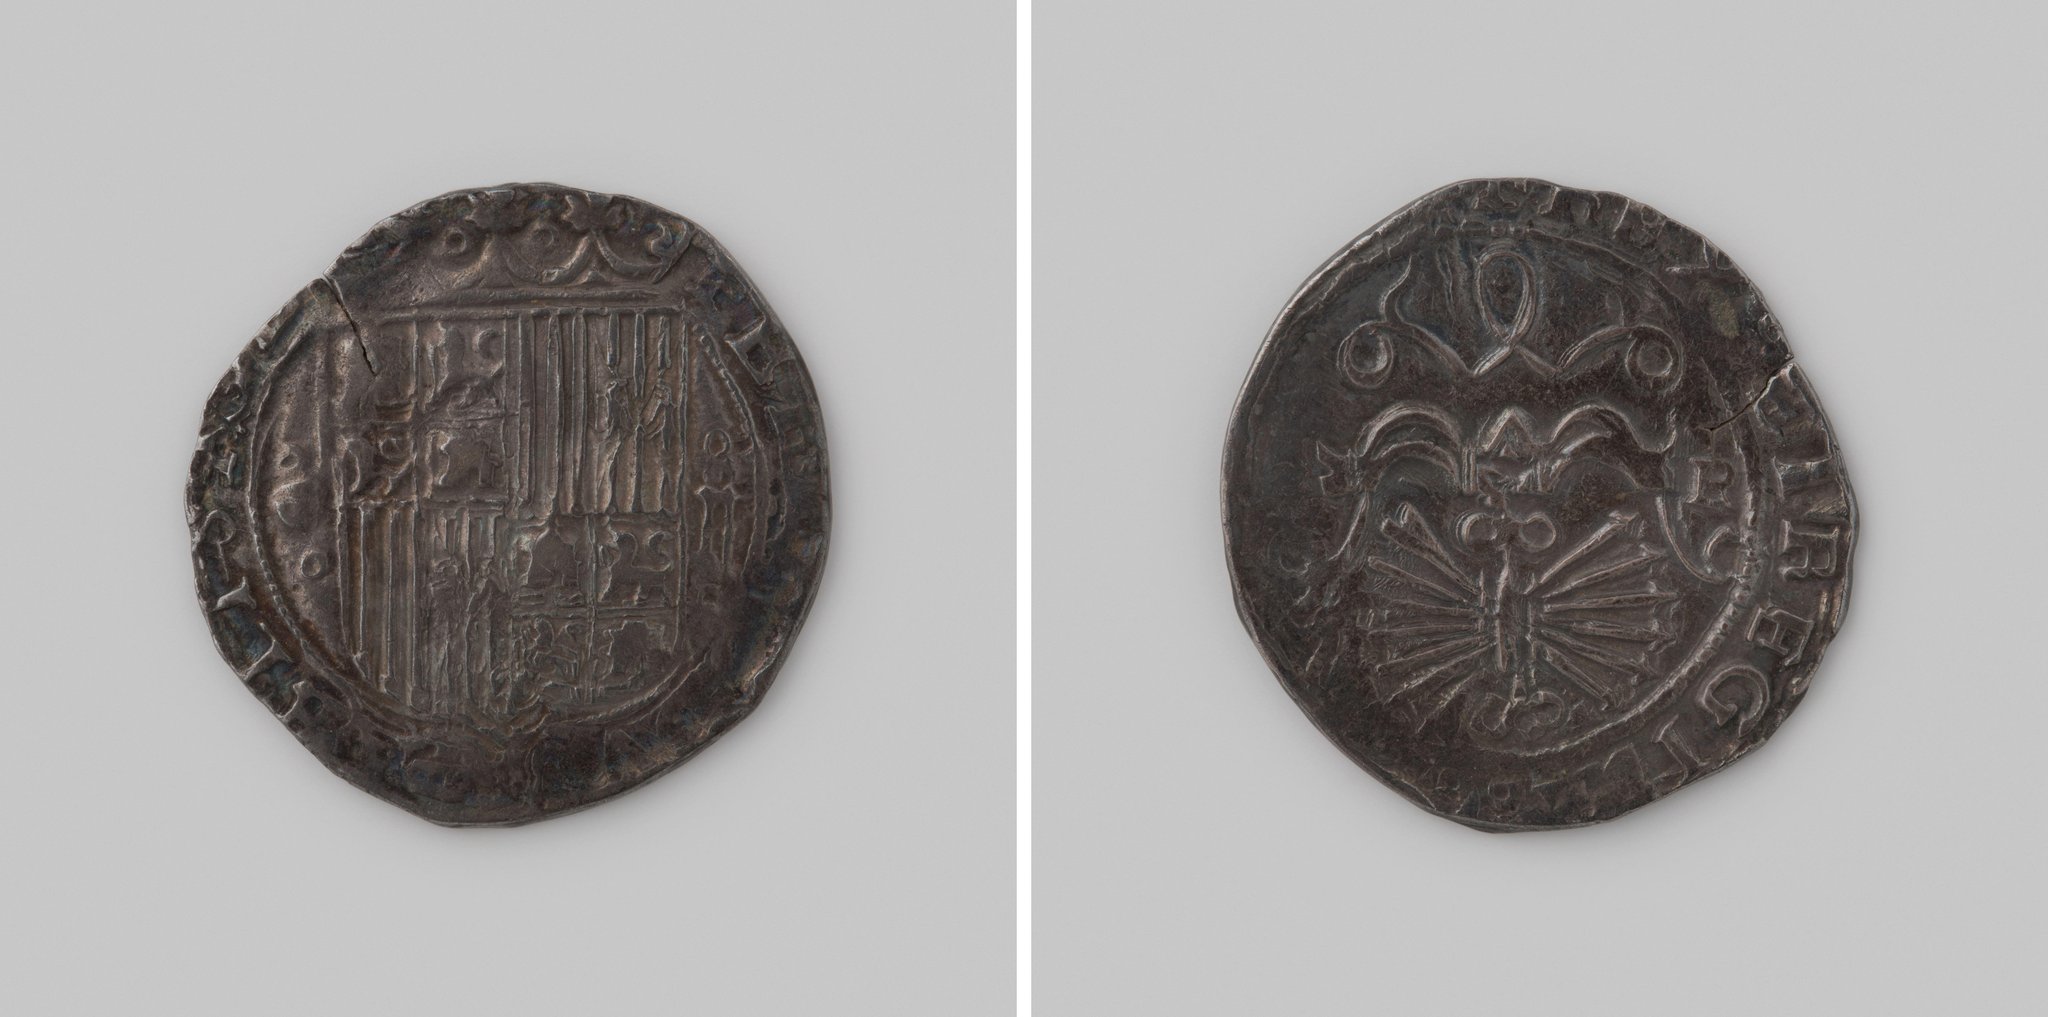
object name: dubbele reaal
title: Dubbele zilveren reaal (dos reales de plata) uit Spanje van koning en koningin Ferdinand en Isabella,1474-1516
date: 1474-1516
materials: silver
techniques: striking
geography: burgos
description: Zilveren munt. Voorzijde: gekroond samengesteld wapenschild. Keerzijde: juk met touw, waaronder pijlenbundel. Rechts van juk letter B [=Burgos].